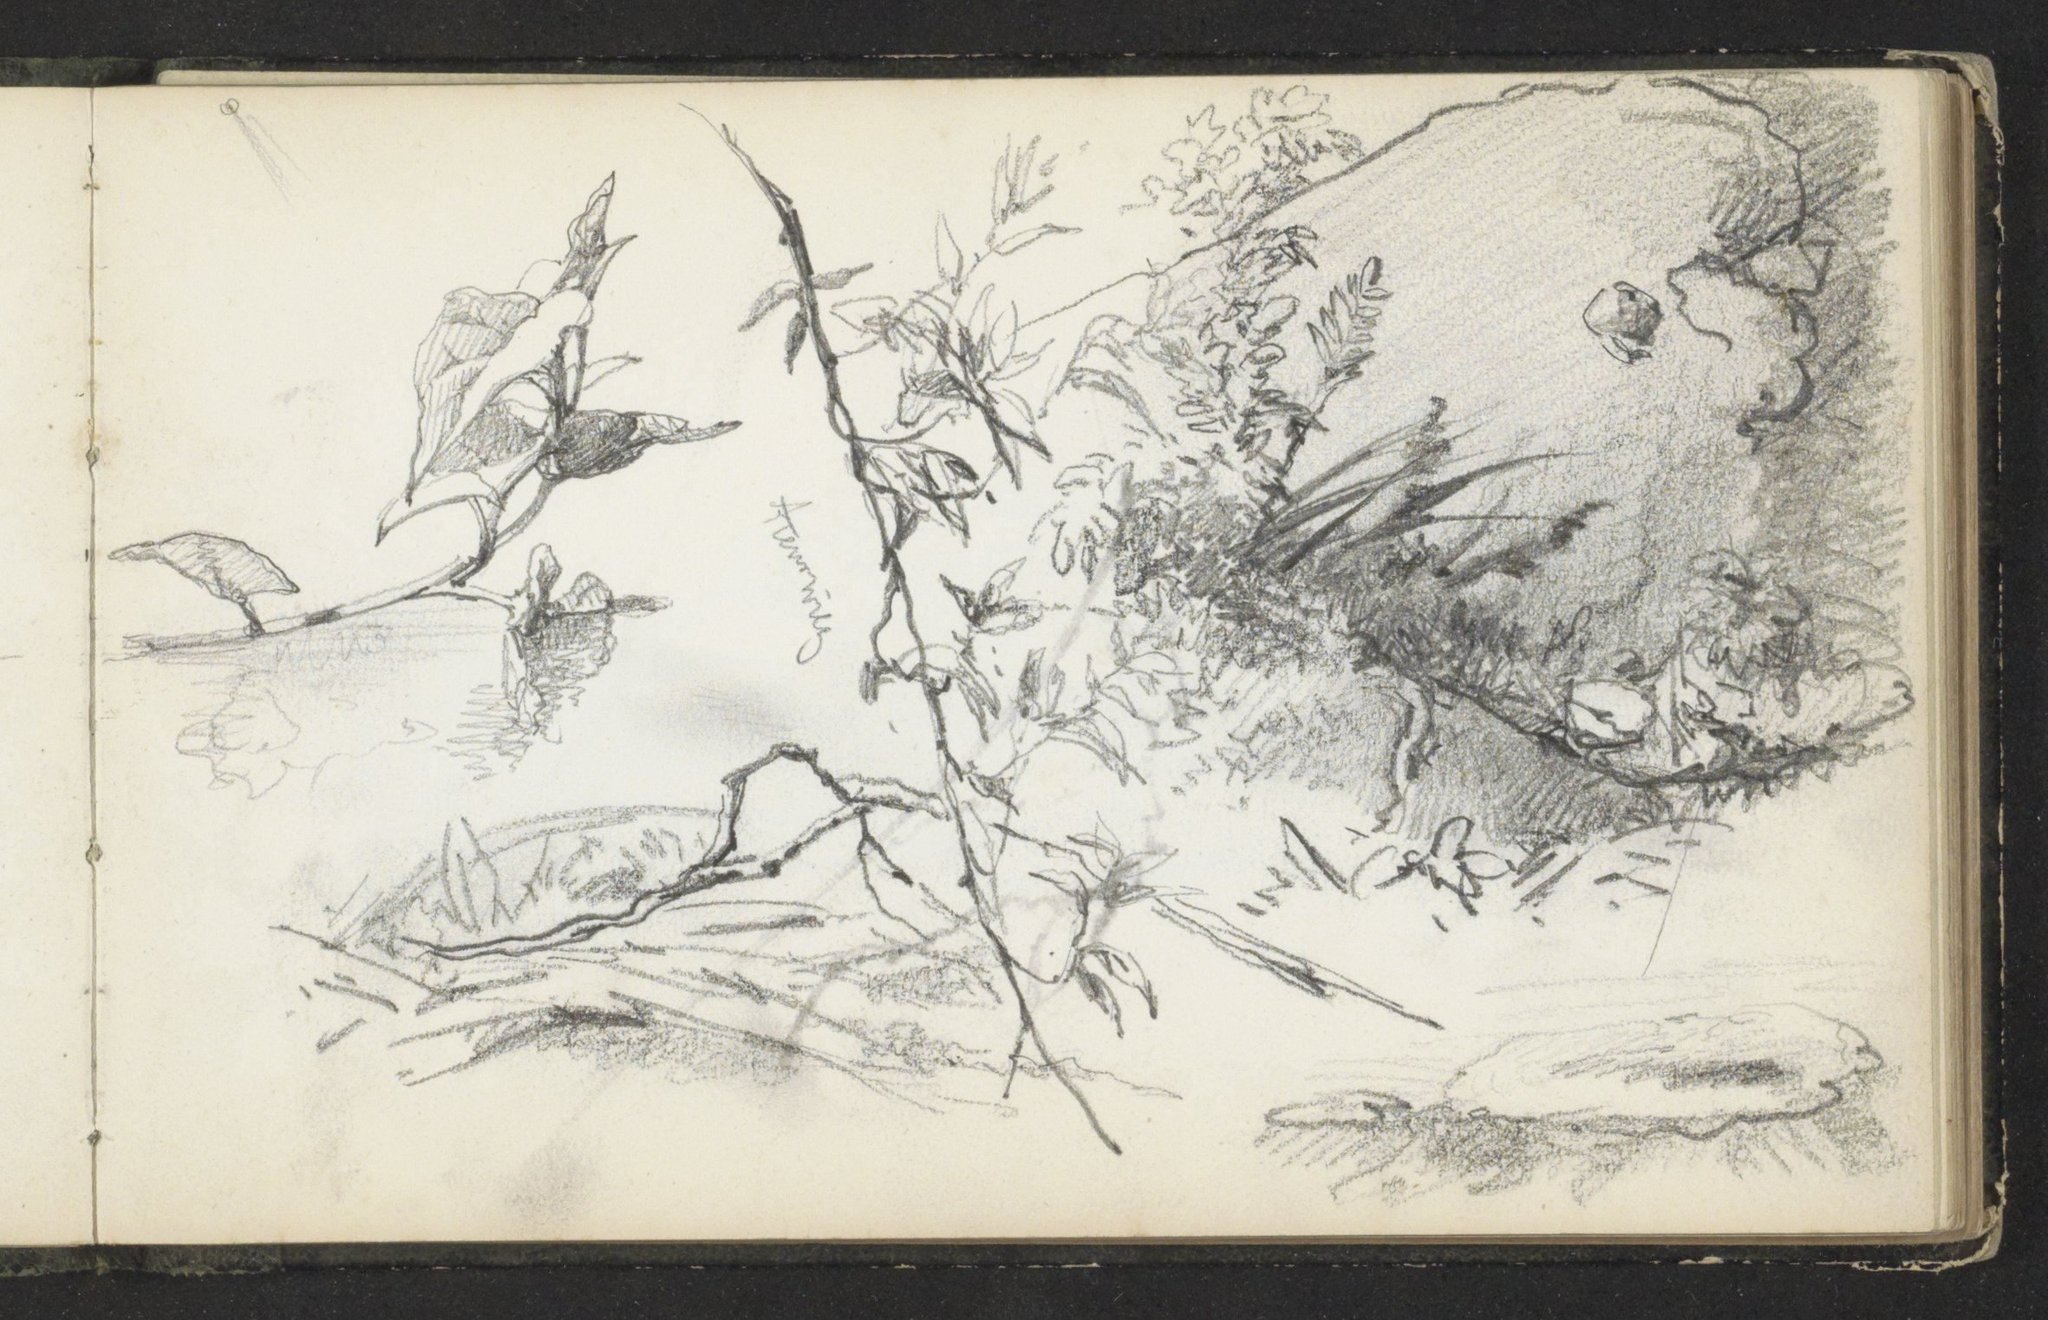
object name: sketchbook leaf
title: Planten en een tak van een treurwilg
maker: maria vos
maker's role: draughtsman, painter, print maker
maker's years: 1824-1906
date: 1856-1870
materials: paper, pencil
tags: plants (in general), trees (+ branch, stick)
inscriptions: annotation: ‘treurwilg’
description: Blad 8 recto uit een schetsboek met 39 bladen.